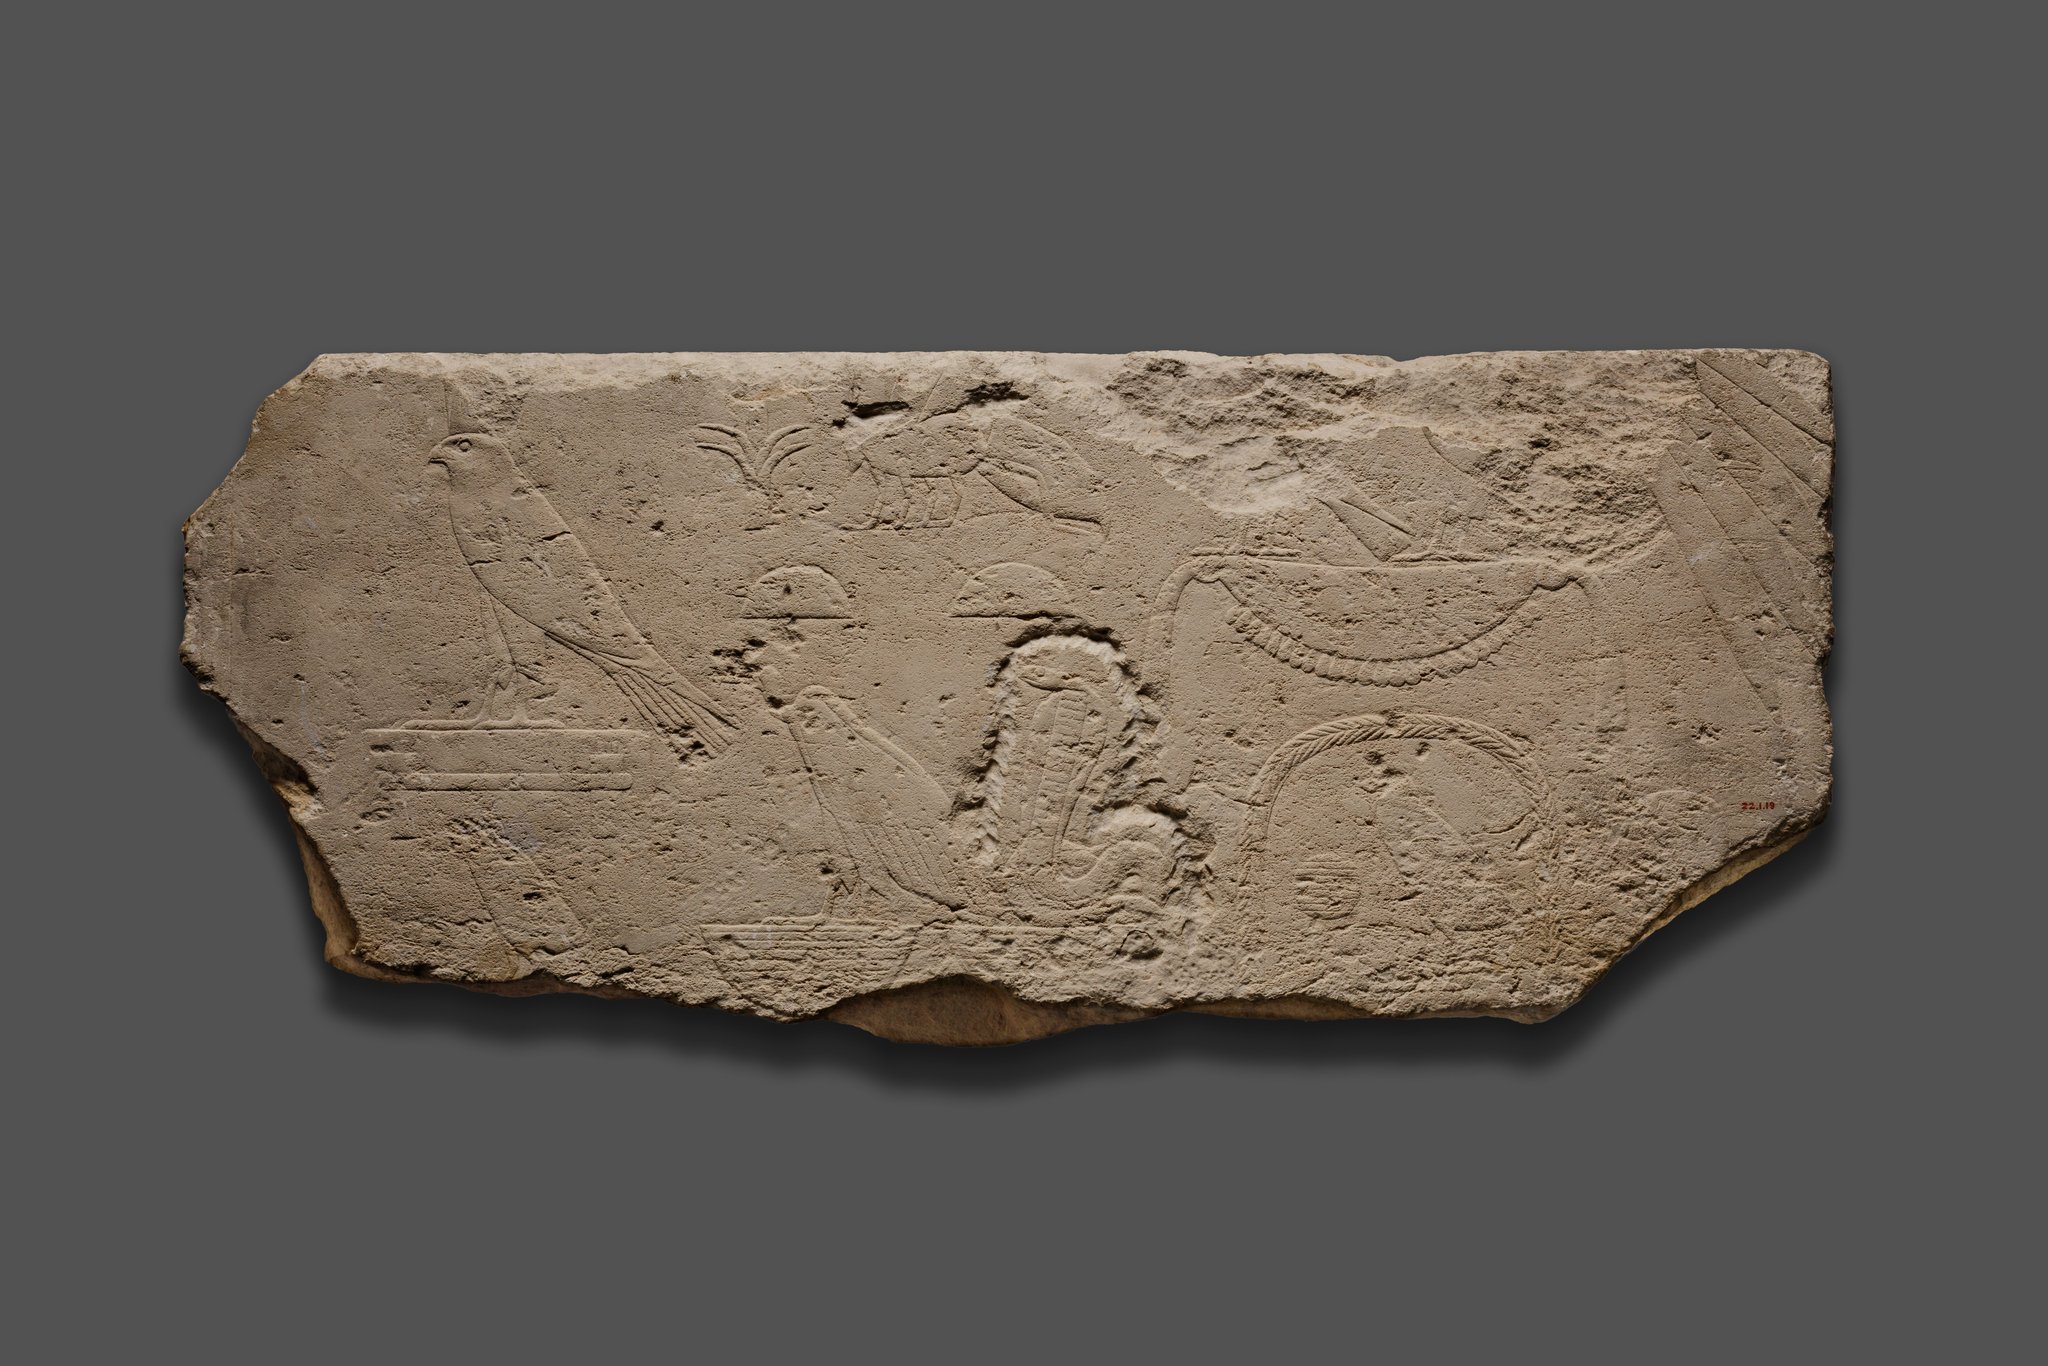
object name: temple relief, name of khufu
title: Temple relief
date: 2551-2528 BCE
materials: limestone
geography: egypt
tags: birds